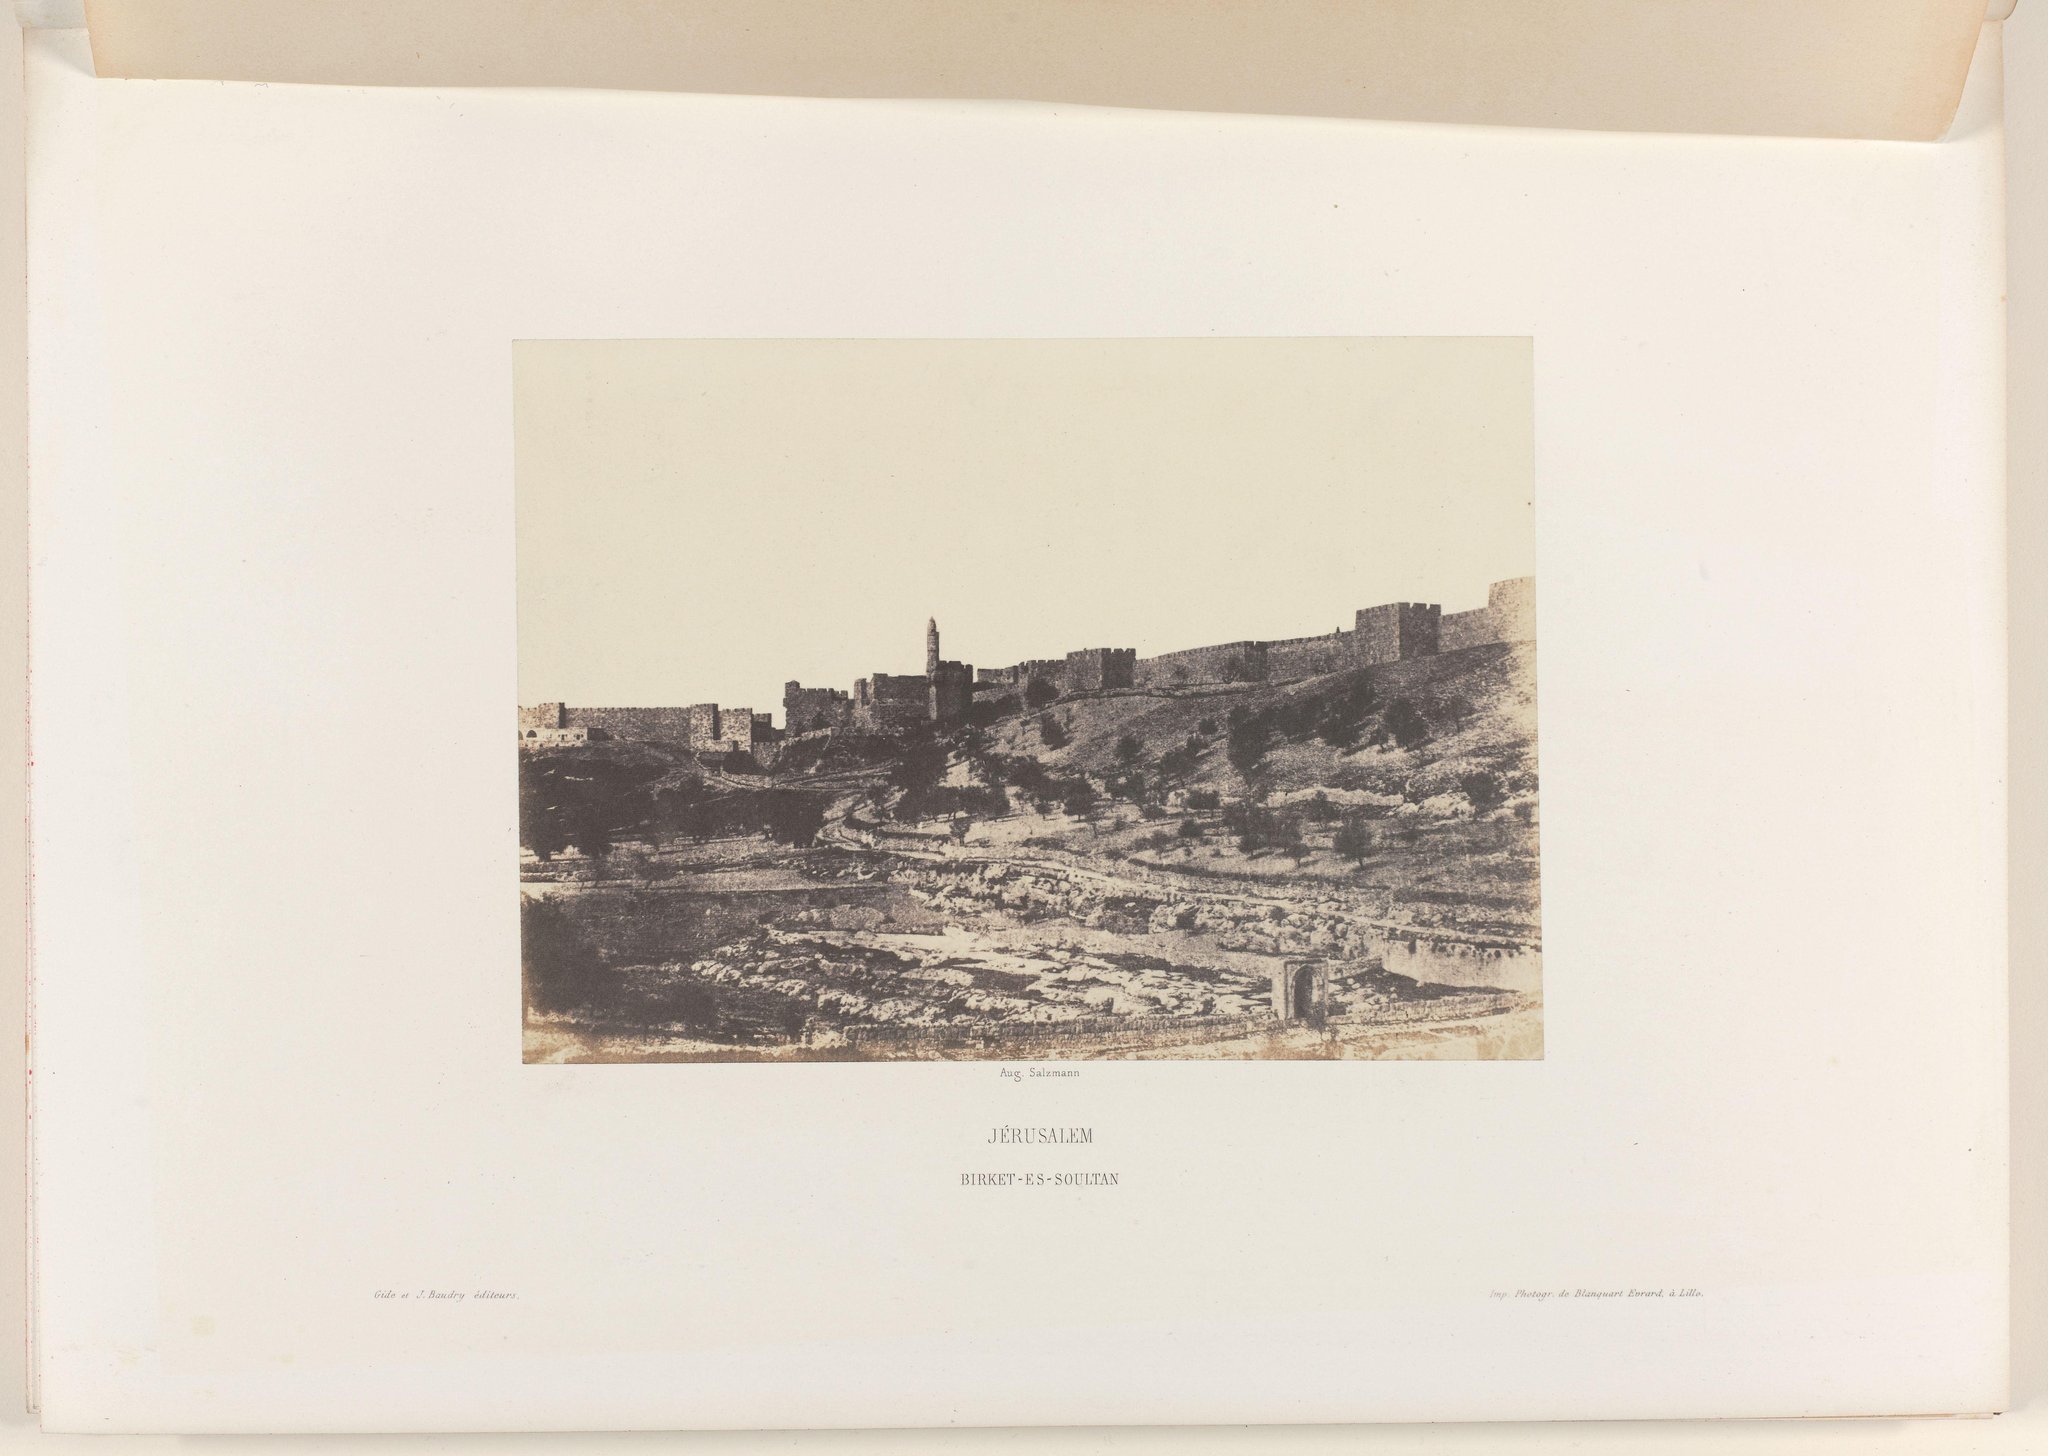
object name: page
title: Bekken van Birket-es-Soultan buiten de oude stadsmuur van Jeruzalem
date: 1854-1856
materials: cardboard, paper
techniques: salted paper print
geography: paris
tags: city-view in general; 'veduta', pond, pool